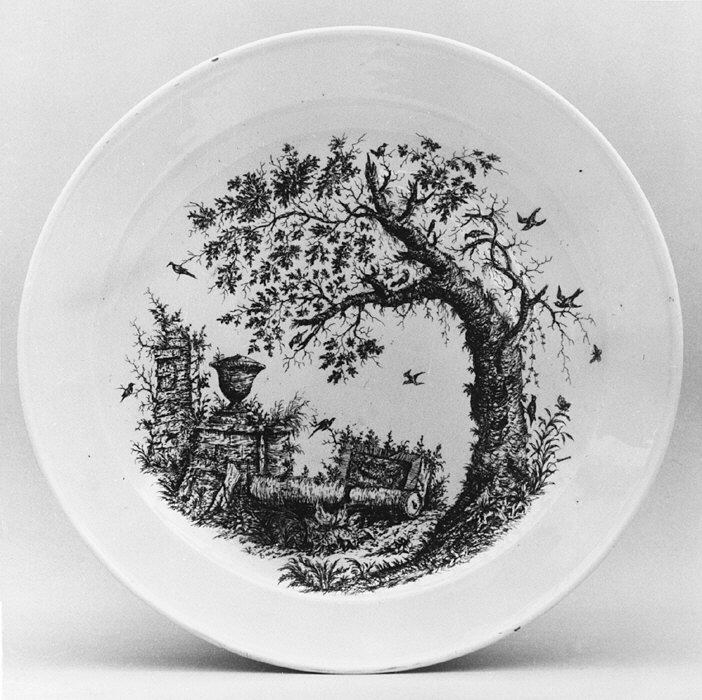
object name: plate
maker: meissen manufactory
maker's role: manufactory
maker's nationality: german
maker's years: 1710-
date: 1756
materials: hard paste porcelain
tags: birds,trees